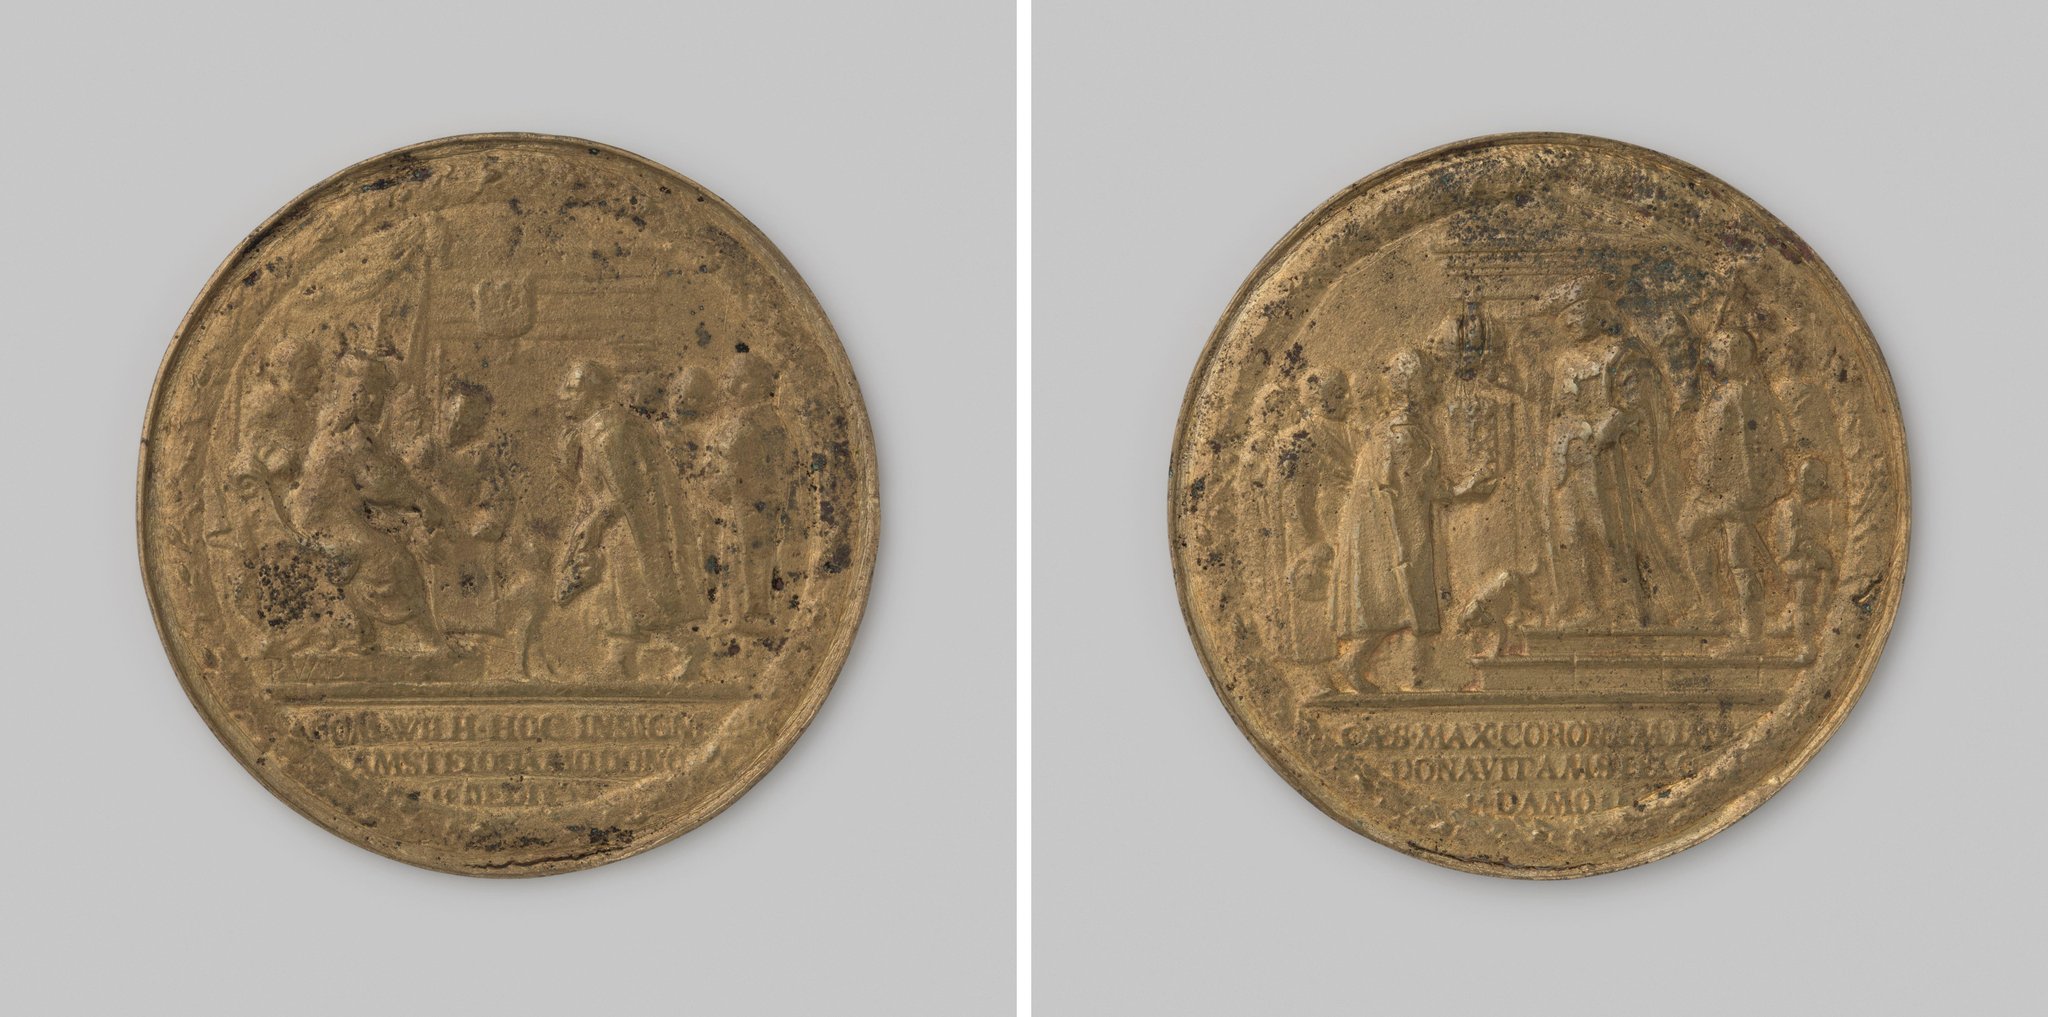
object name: history medal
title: Honderdjarige herdenking van de verlening van het recht een keizerskroon boven het wapen te dragen door Keizer Maximiliaan aan Amsterdam 1578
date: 1578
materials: brass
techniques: casting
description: Grote messing penning, op de voorzijde binnen een krans de getroonde Graaf Willem die het Hollandse wapenschild ontvangt, met opschrift in de afsnede, op de keerzijde binnen een krans Maximiliaan die een keizerskroon boven het wapen houdt, met opschrift in de afsnede